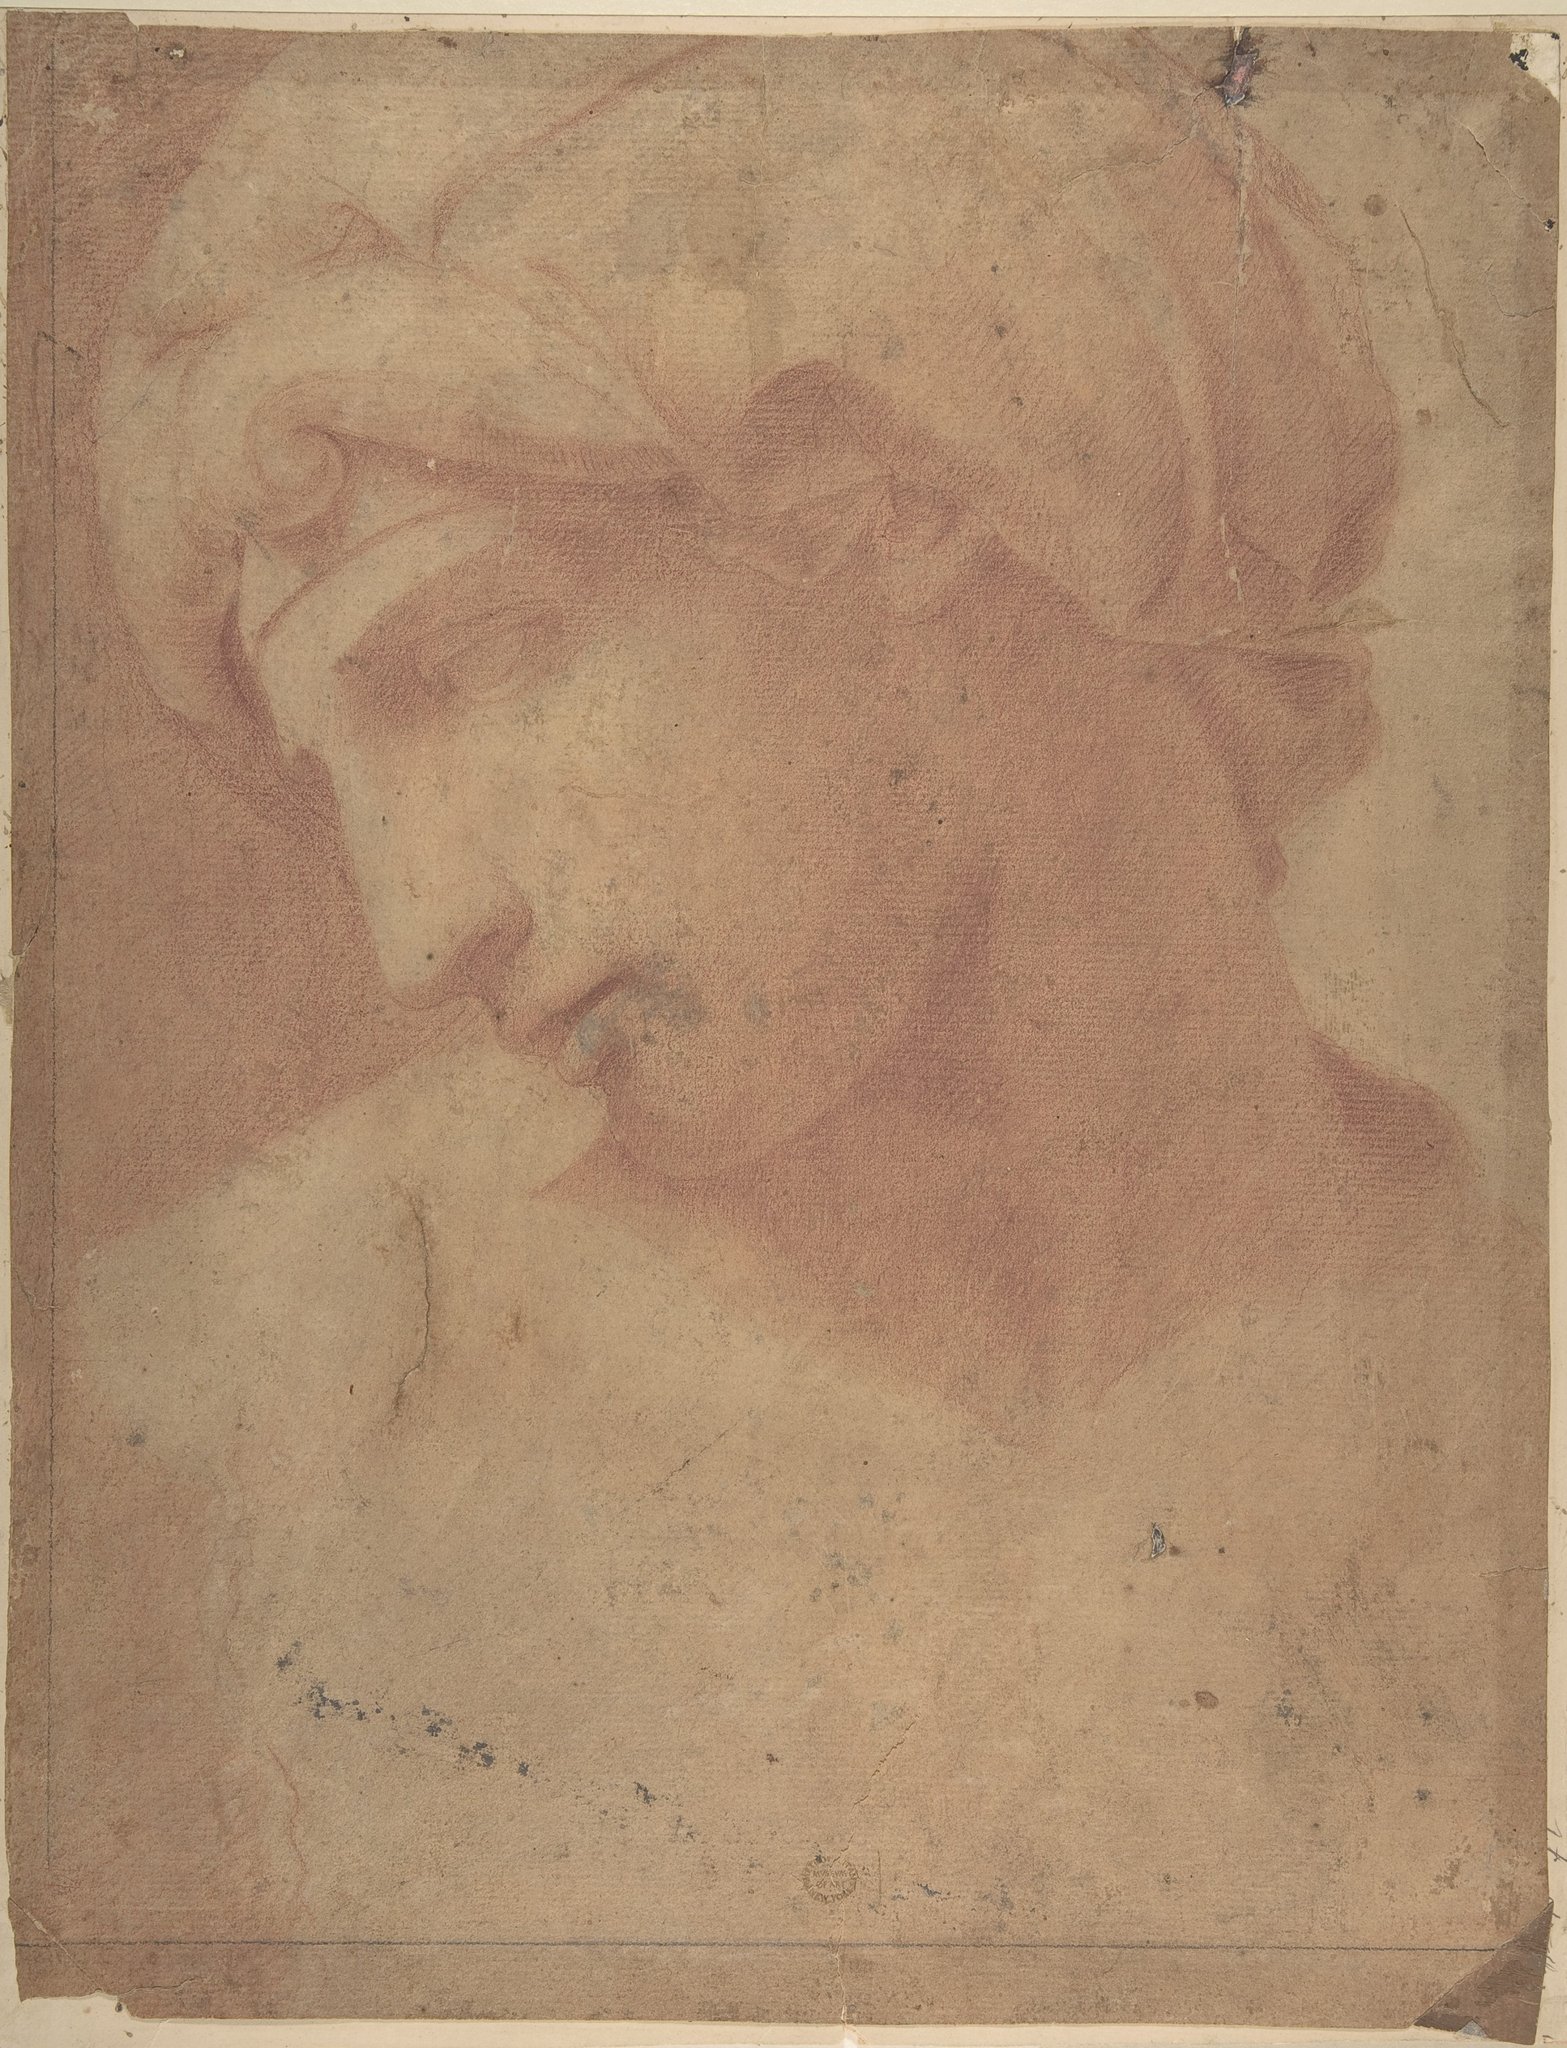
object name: drawing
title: Drawing of the Head of Michelangelo's Dawn (from the Tomb of Lorenzo de' Medici, Church of San Lorenzo, Florence)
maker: Anonymous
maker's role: artist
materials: chalk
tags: heads,women